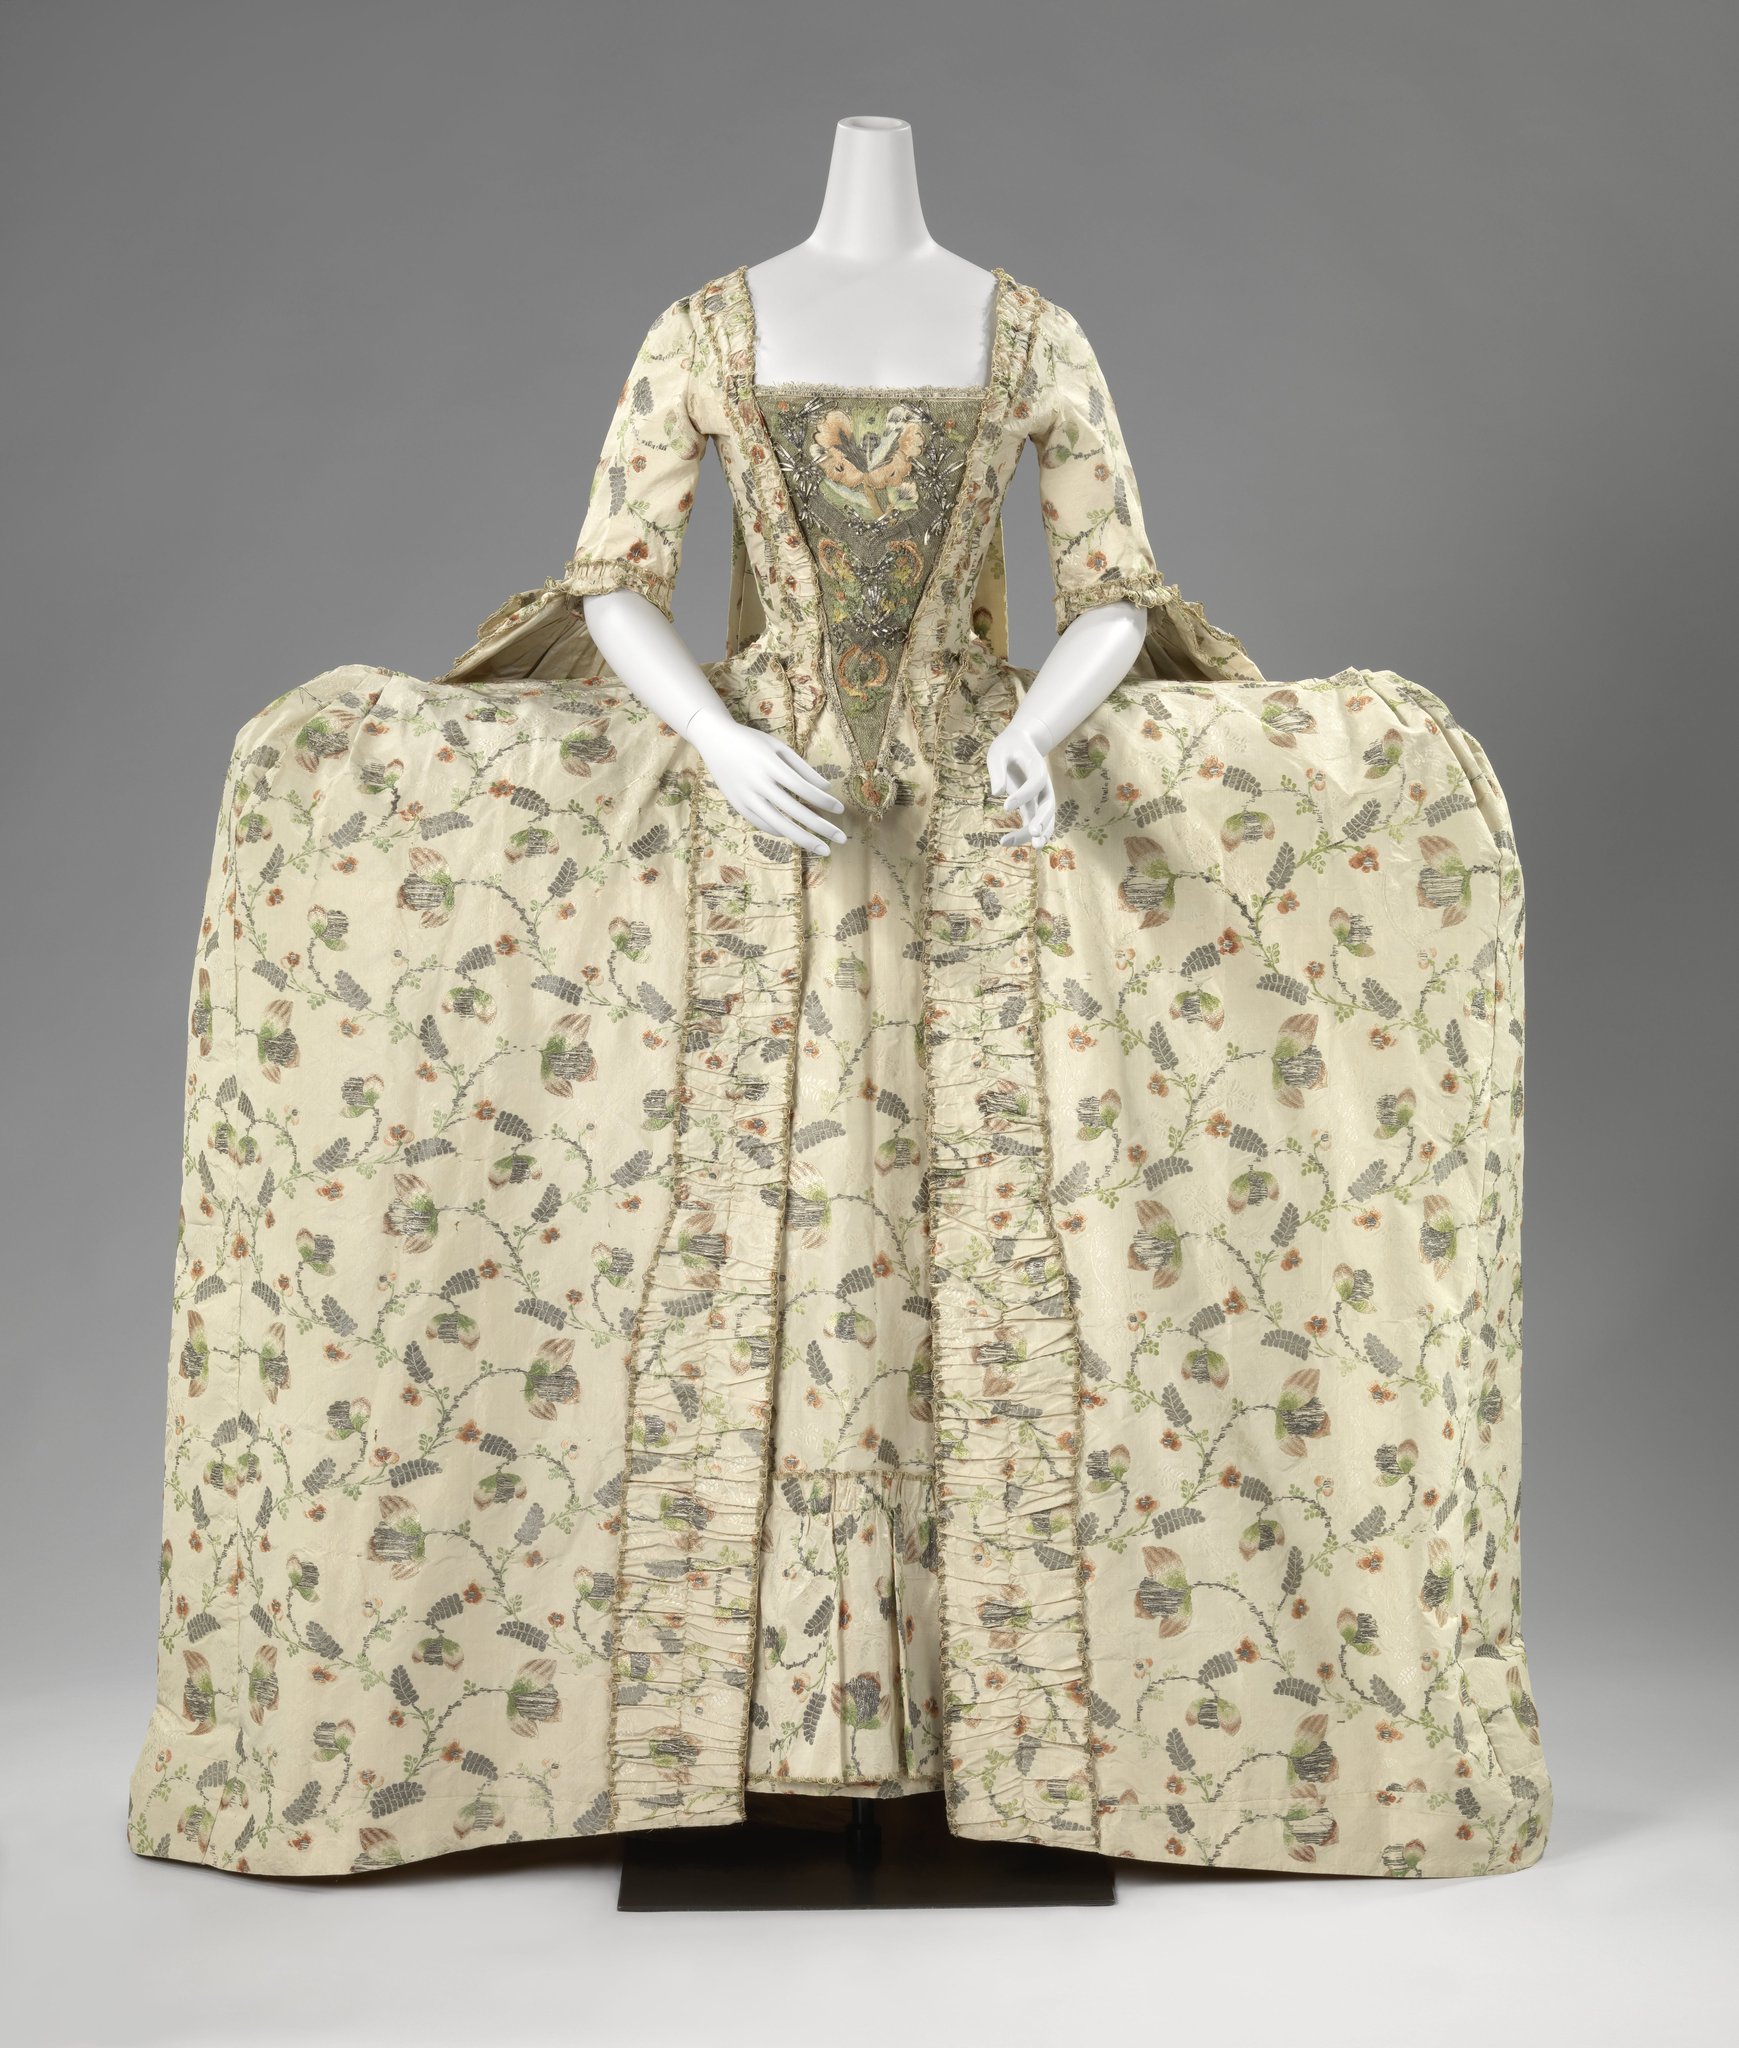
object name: robe à la française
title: Overjapon of manteau van zijden brokaat, met een crèmekleurig fond waarop veelkleurige zijden, gouden en zilveren bloemen zijn geweven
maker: Anonymous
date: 1765-1775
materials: silk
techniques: brocade, weave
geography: netherlands